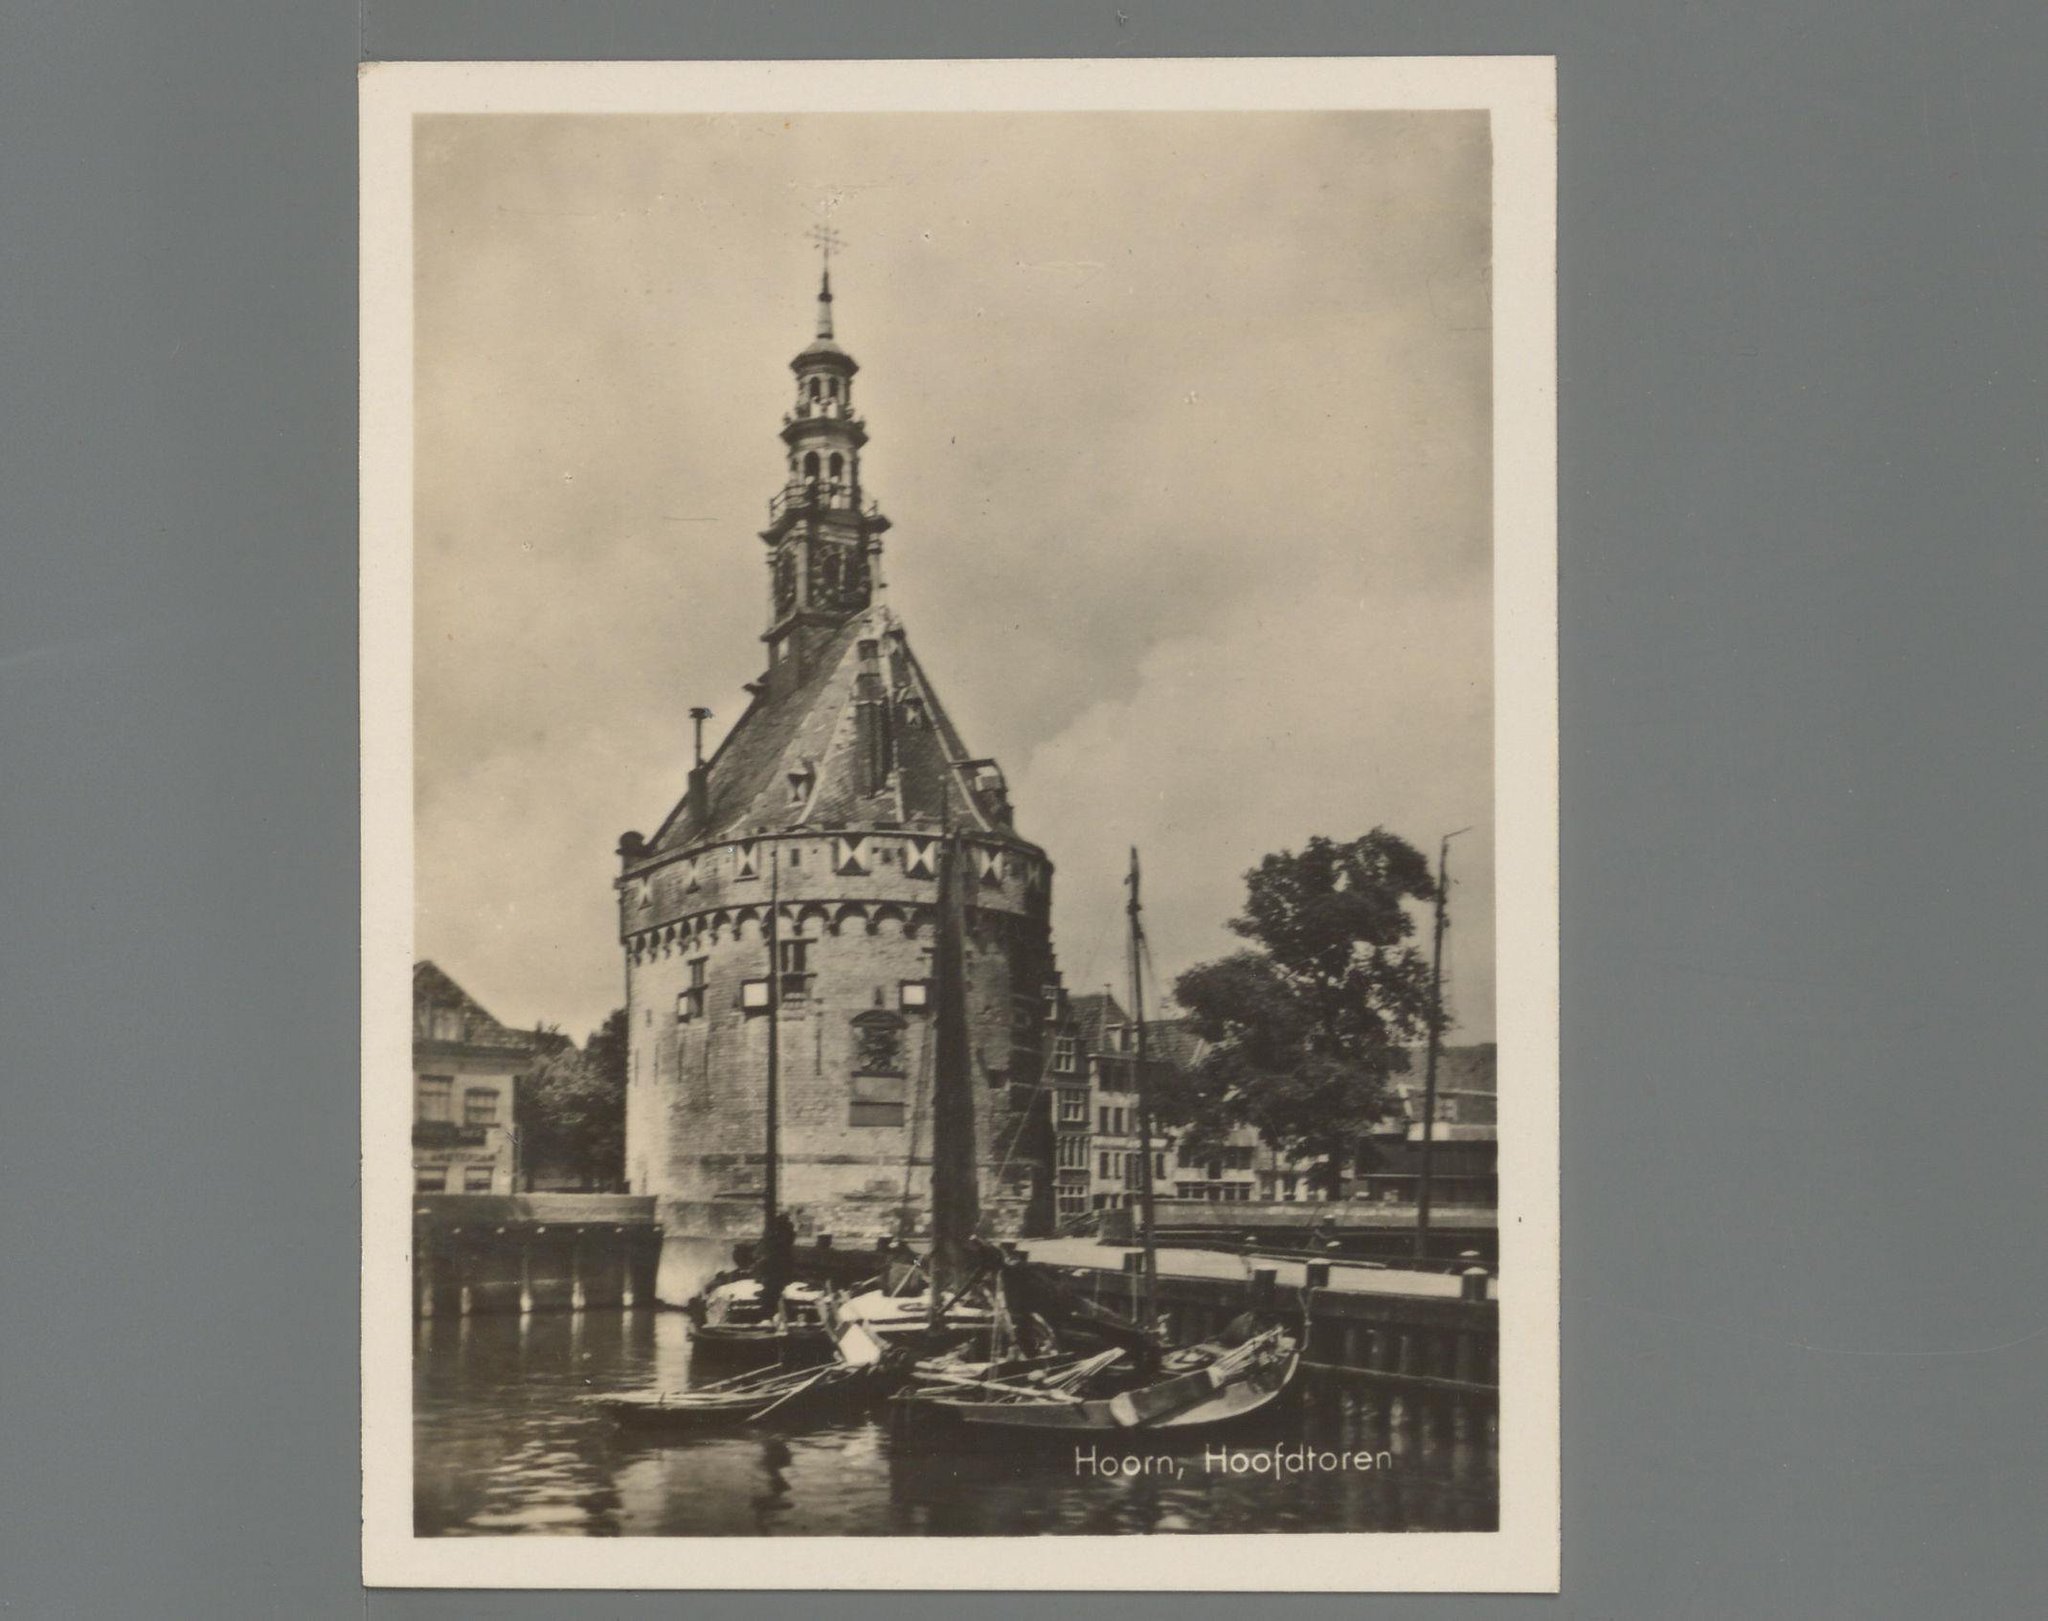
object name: photograph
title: Hoorn, Hoofdtoren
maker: Anonymous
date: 1900-1950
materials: paper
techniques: gelatin silver print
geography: hoorn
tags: landscape with tower or castle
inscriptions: inscription: ‘Dromedaris Enkhuizen’